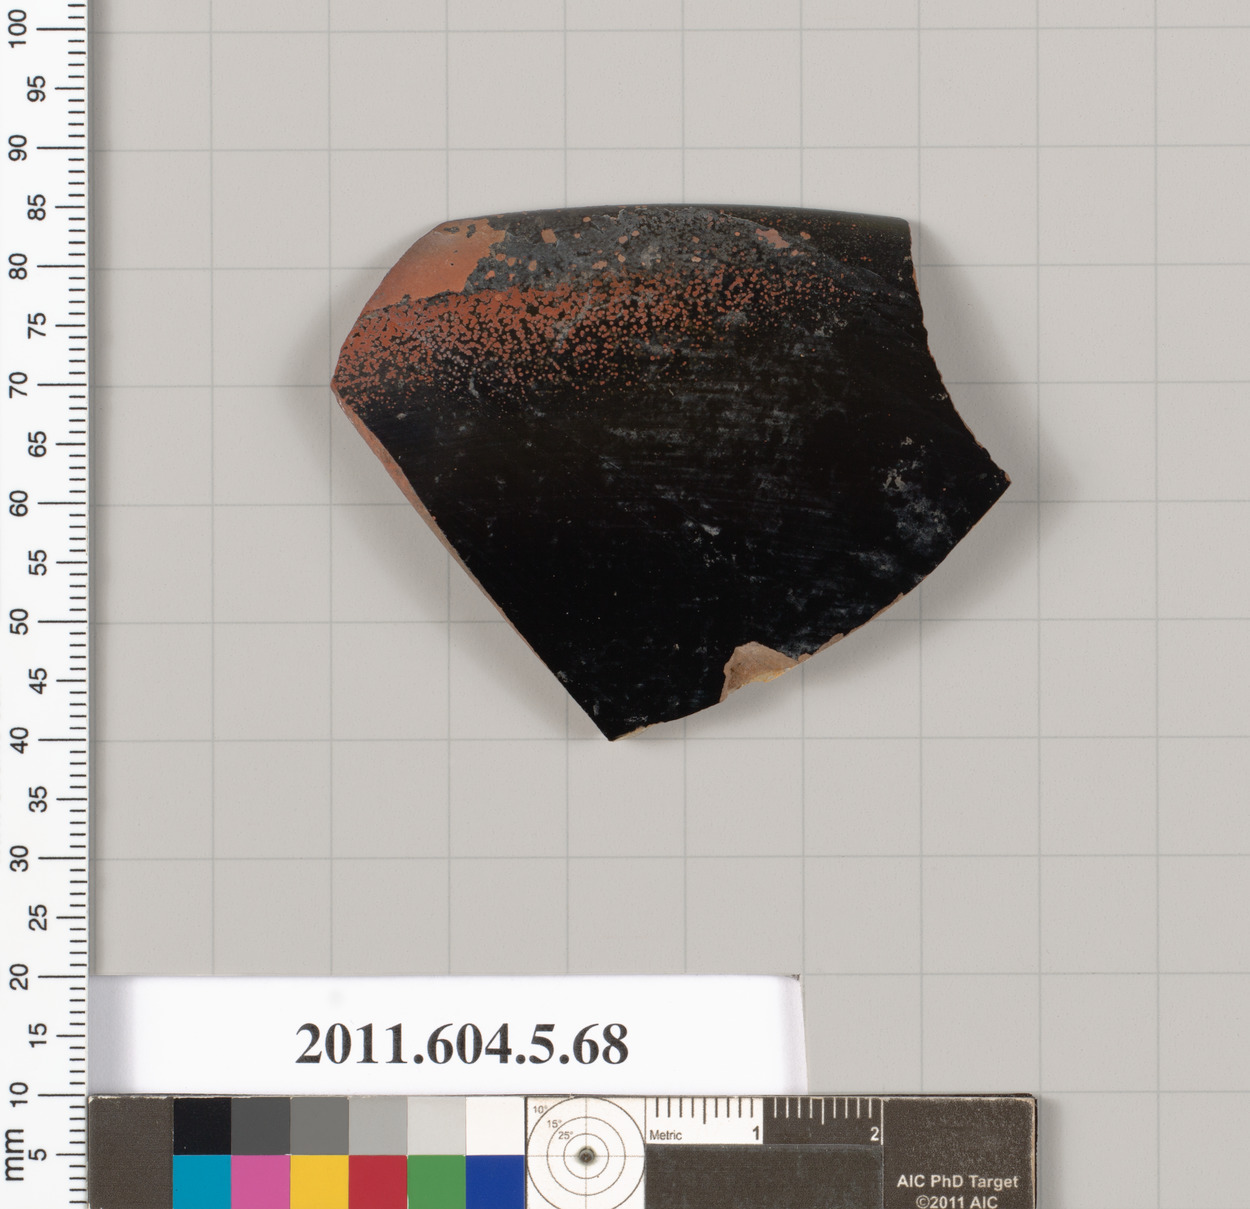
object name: kylix fragment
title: Terracotta rim fragment of a kylix (drinking cup)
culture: greek, attic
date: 500-476 BCE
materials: terracotta